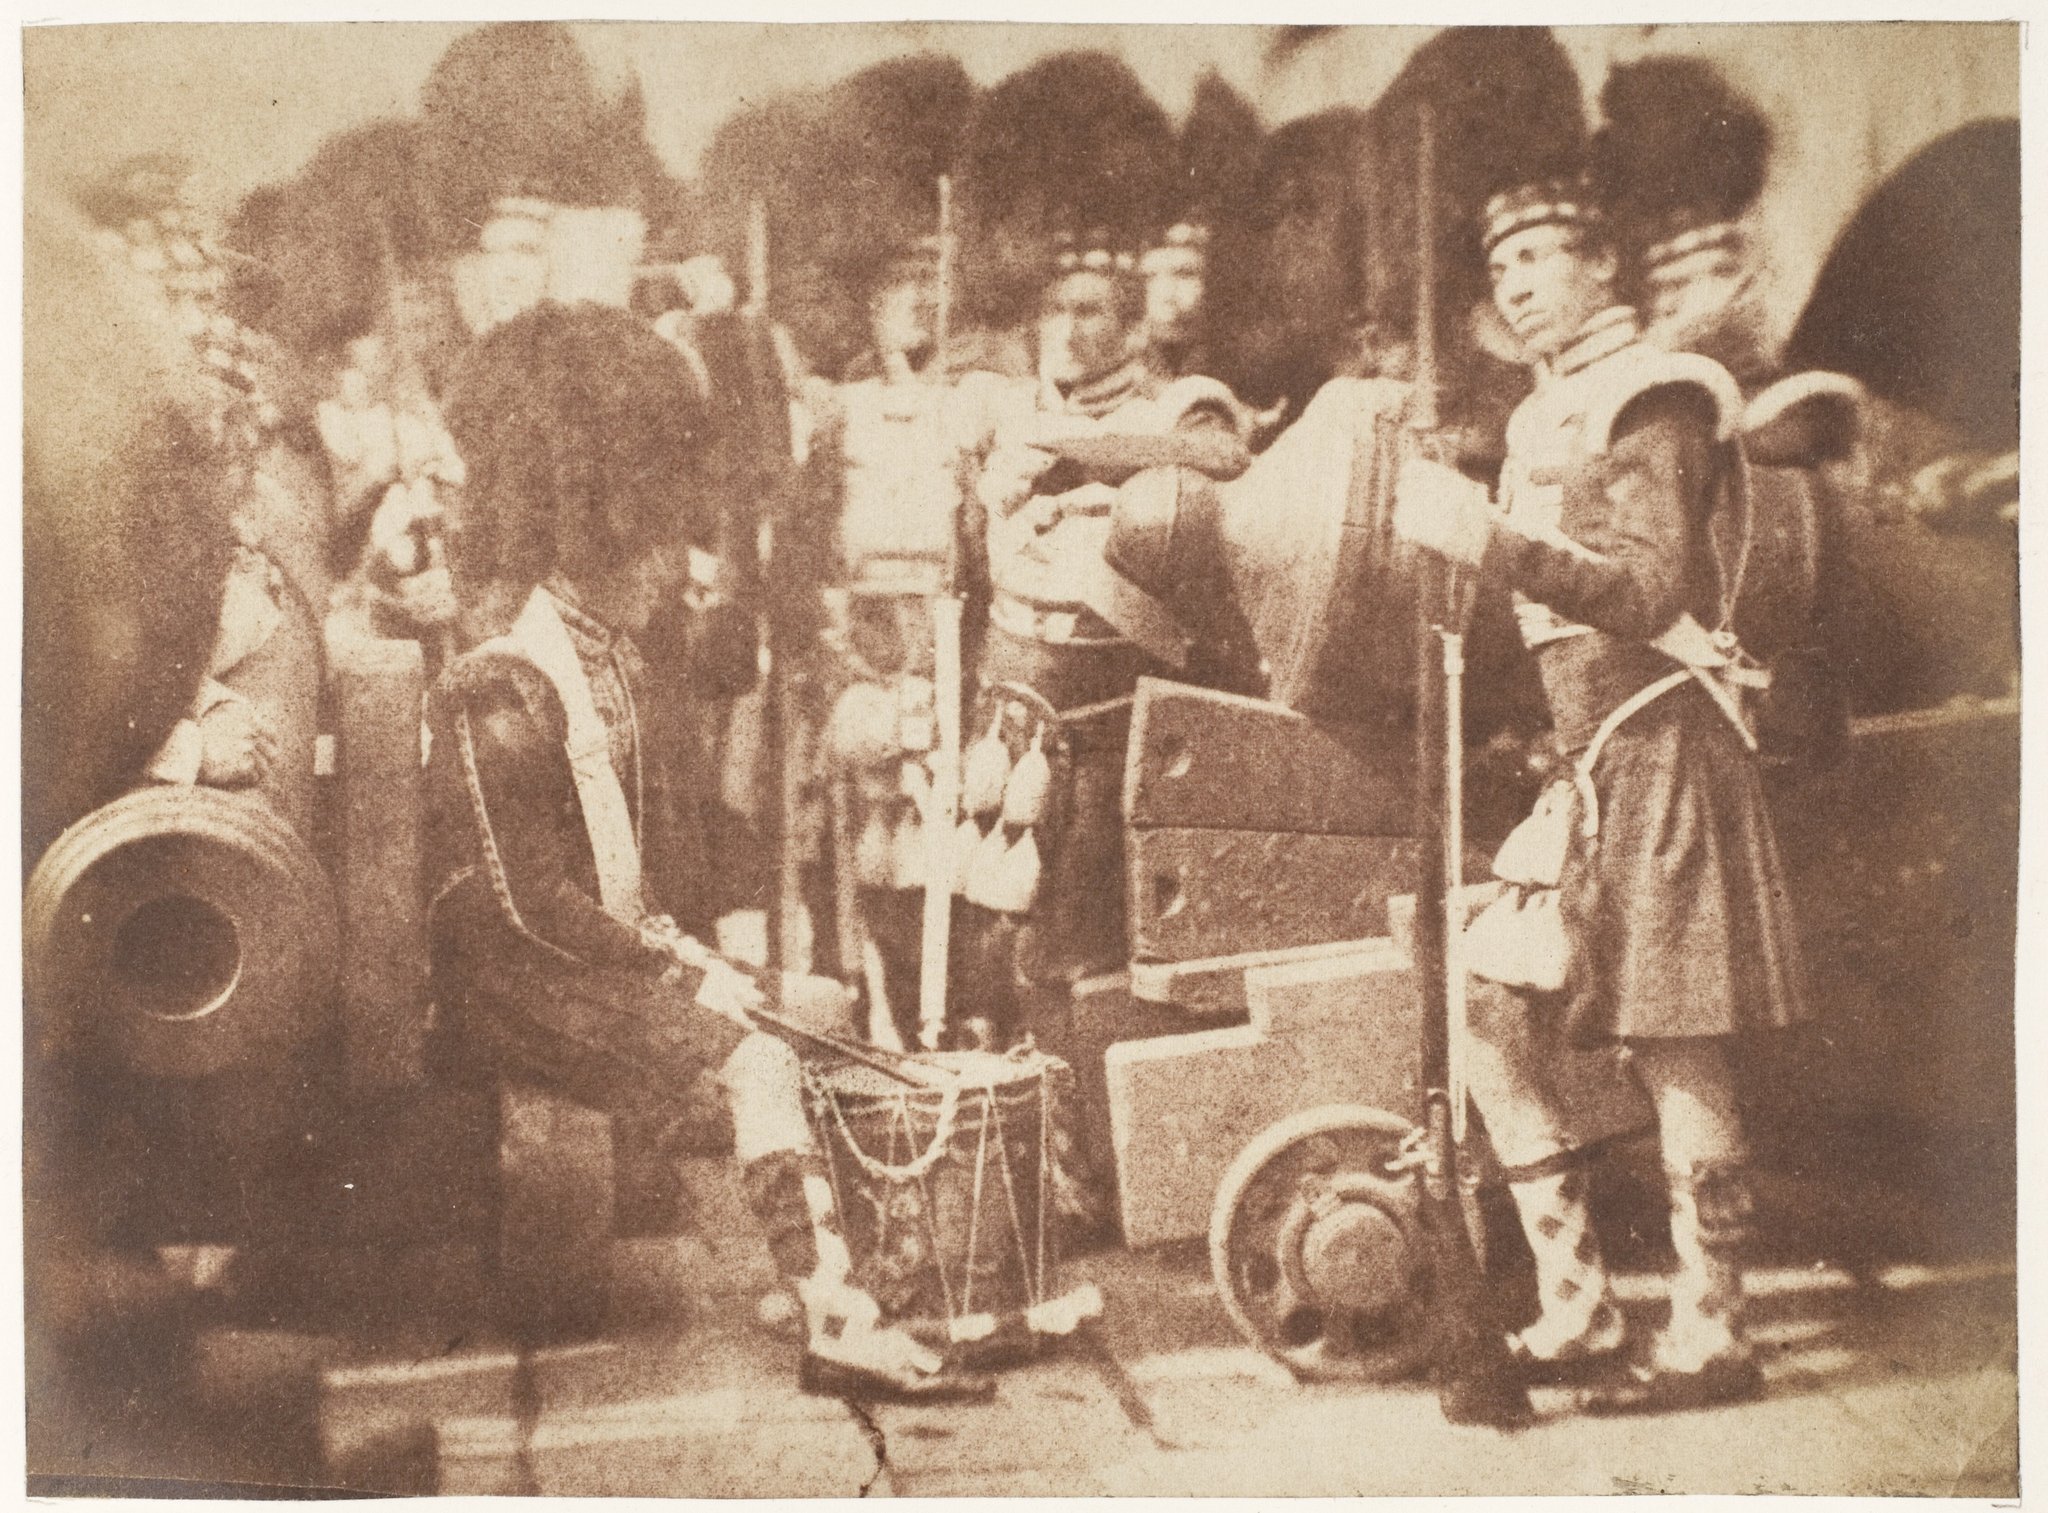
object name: photograph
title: The 42nd Gordon Highlanders, Edinburgh Castle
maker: hill and adamson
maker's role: photography studio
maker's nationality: british, scottish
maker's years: 1843-1848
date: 1843-1847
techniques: paper negative, salted paper print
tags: soldiers,cannons,men,drums